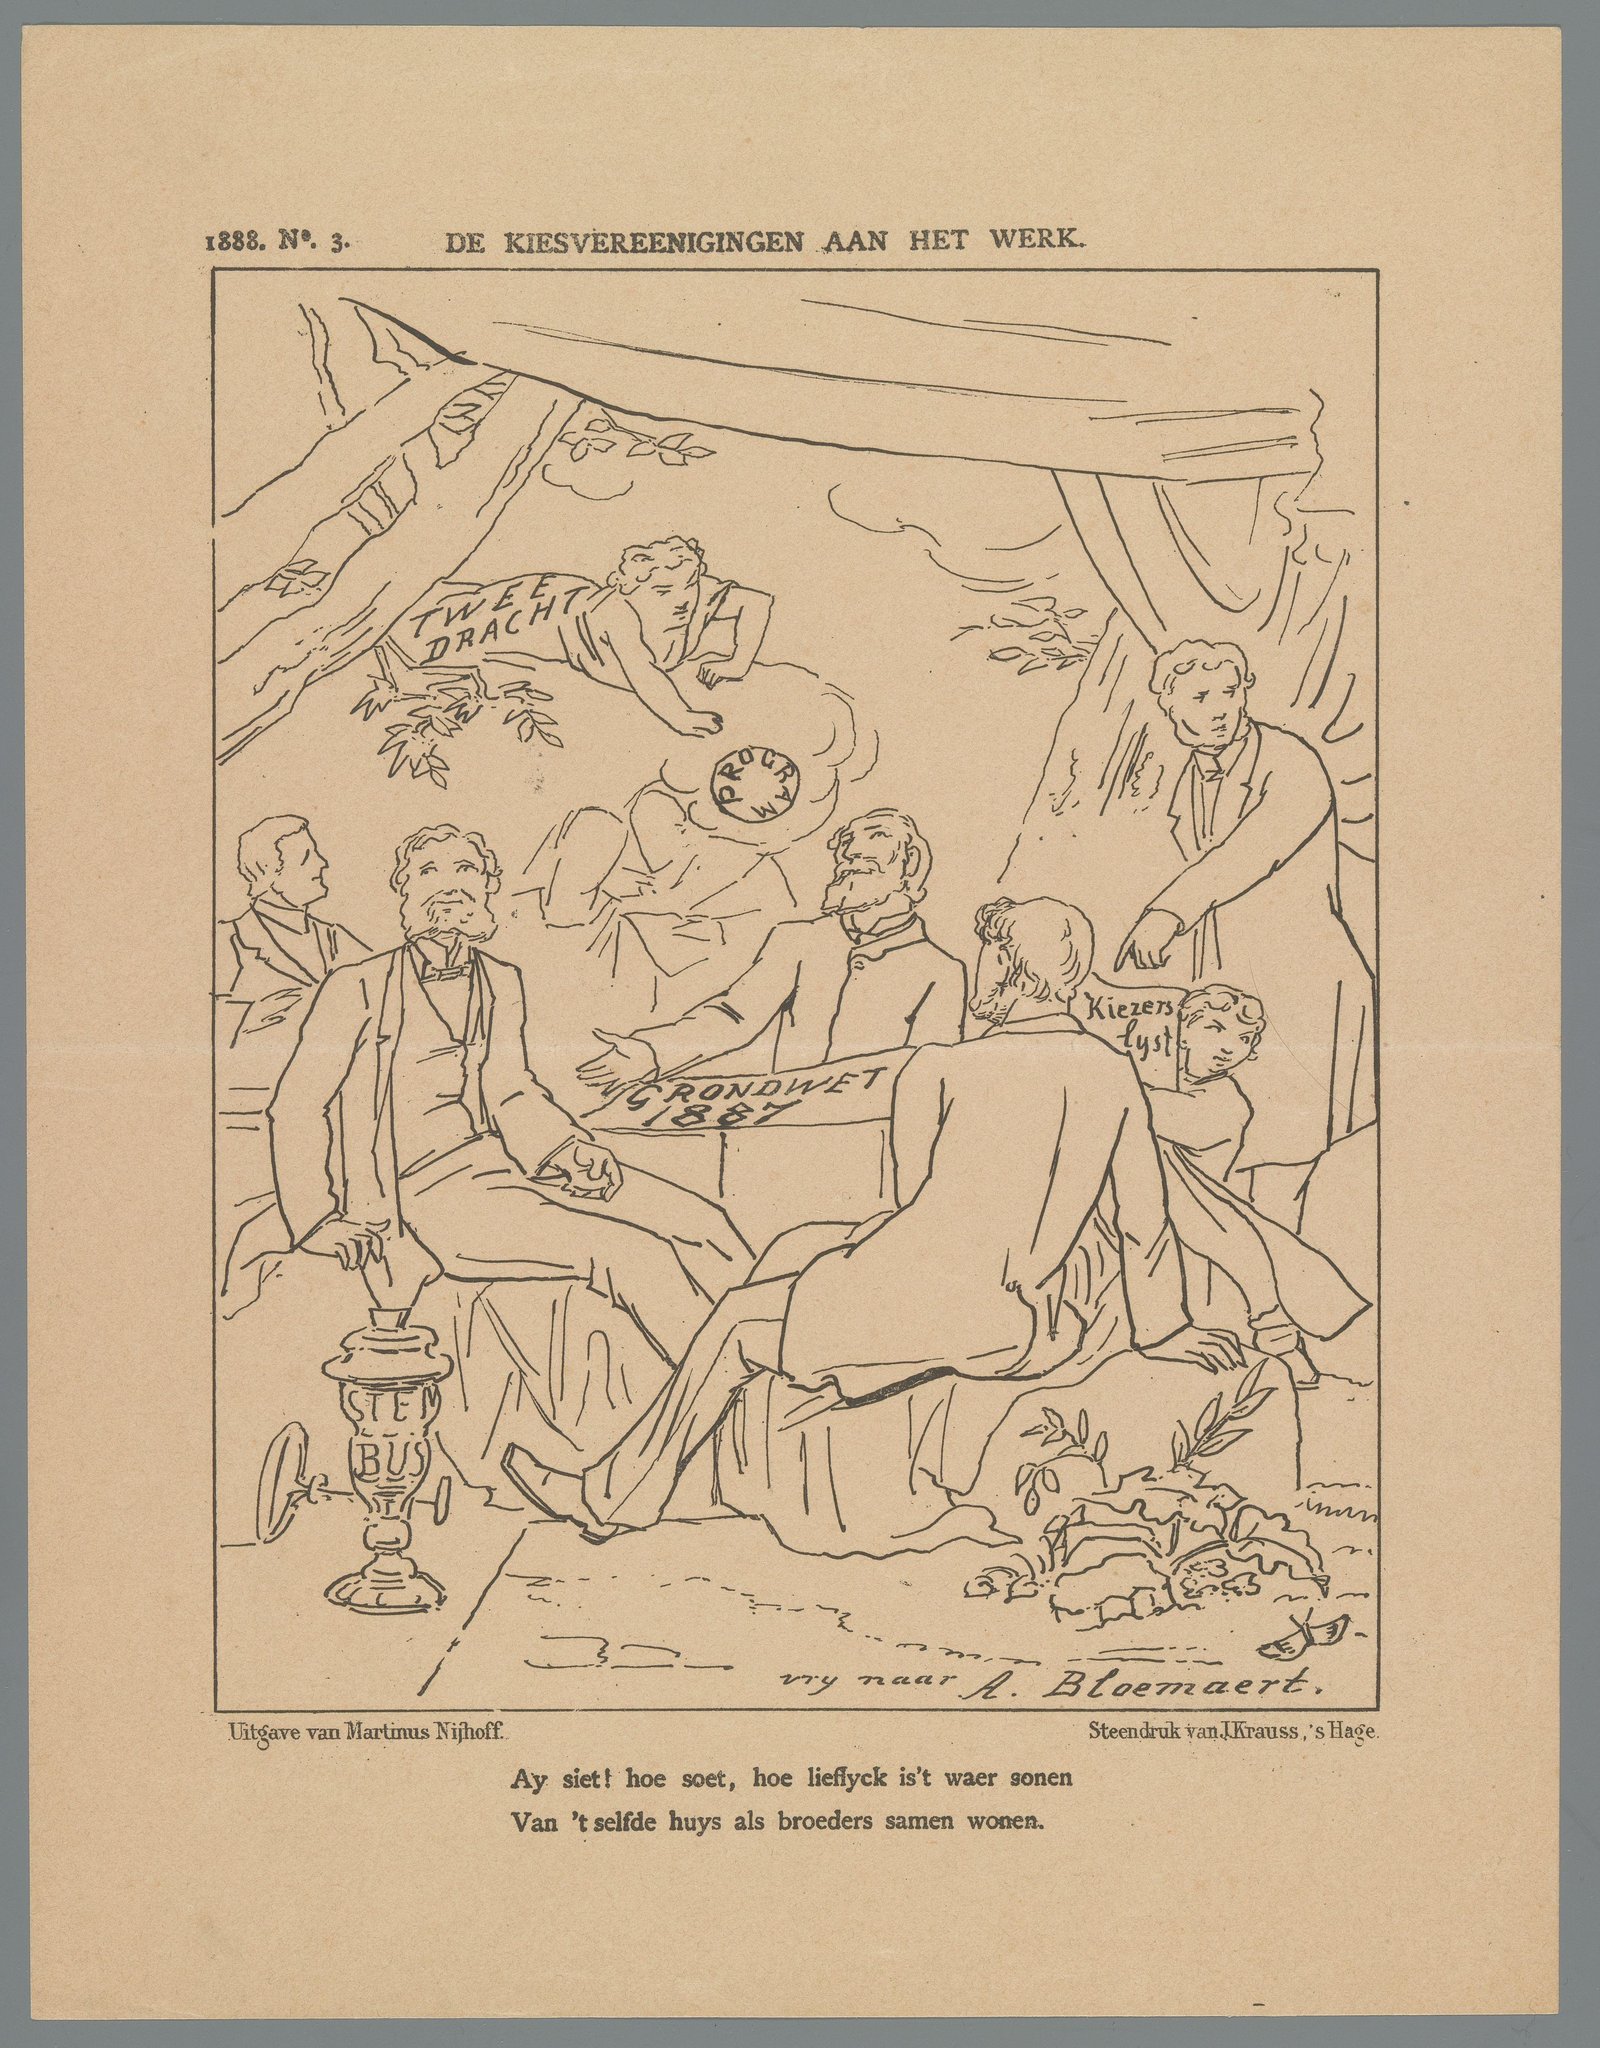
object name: print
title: Spotprent over de kiesverenigingen, 1888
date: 1888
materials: paper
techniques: lithograph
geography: netherlands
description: Spotprent over de kiesverenigingen. Plaat verschenen bij het weekblad De Nederlandsche Spectator, nr. 3, 1888.